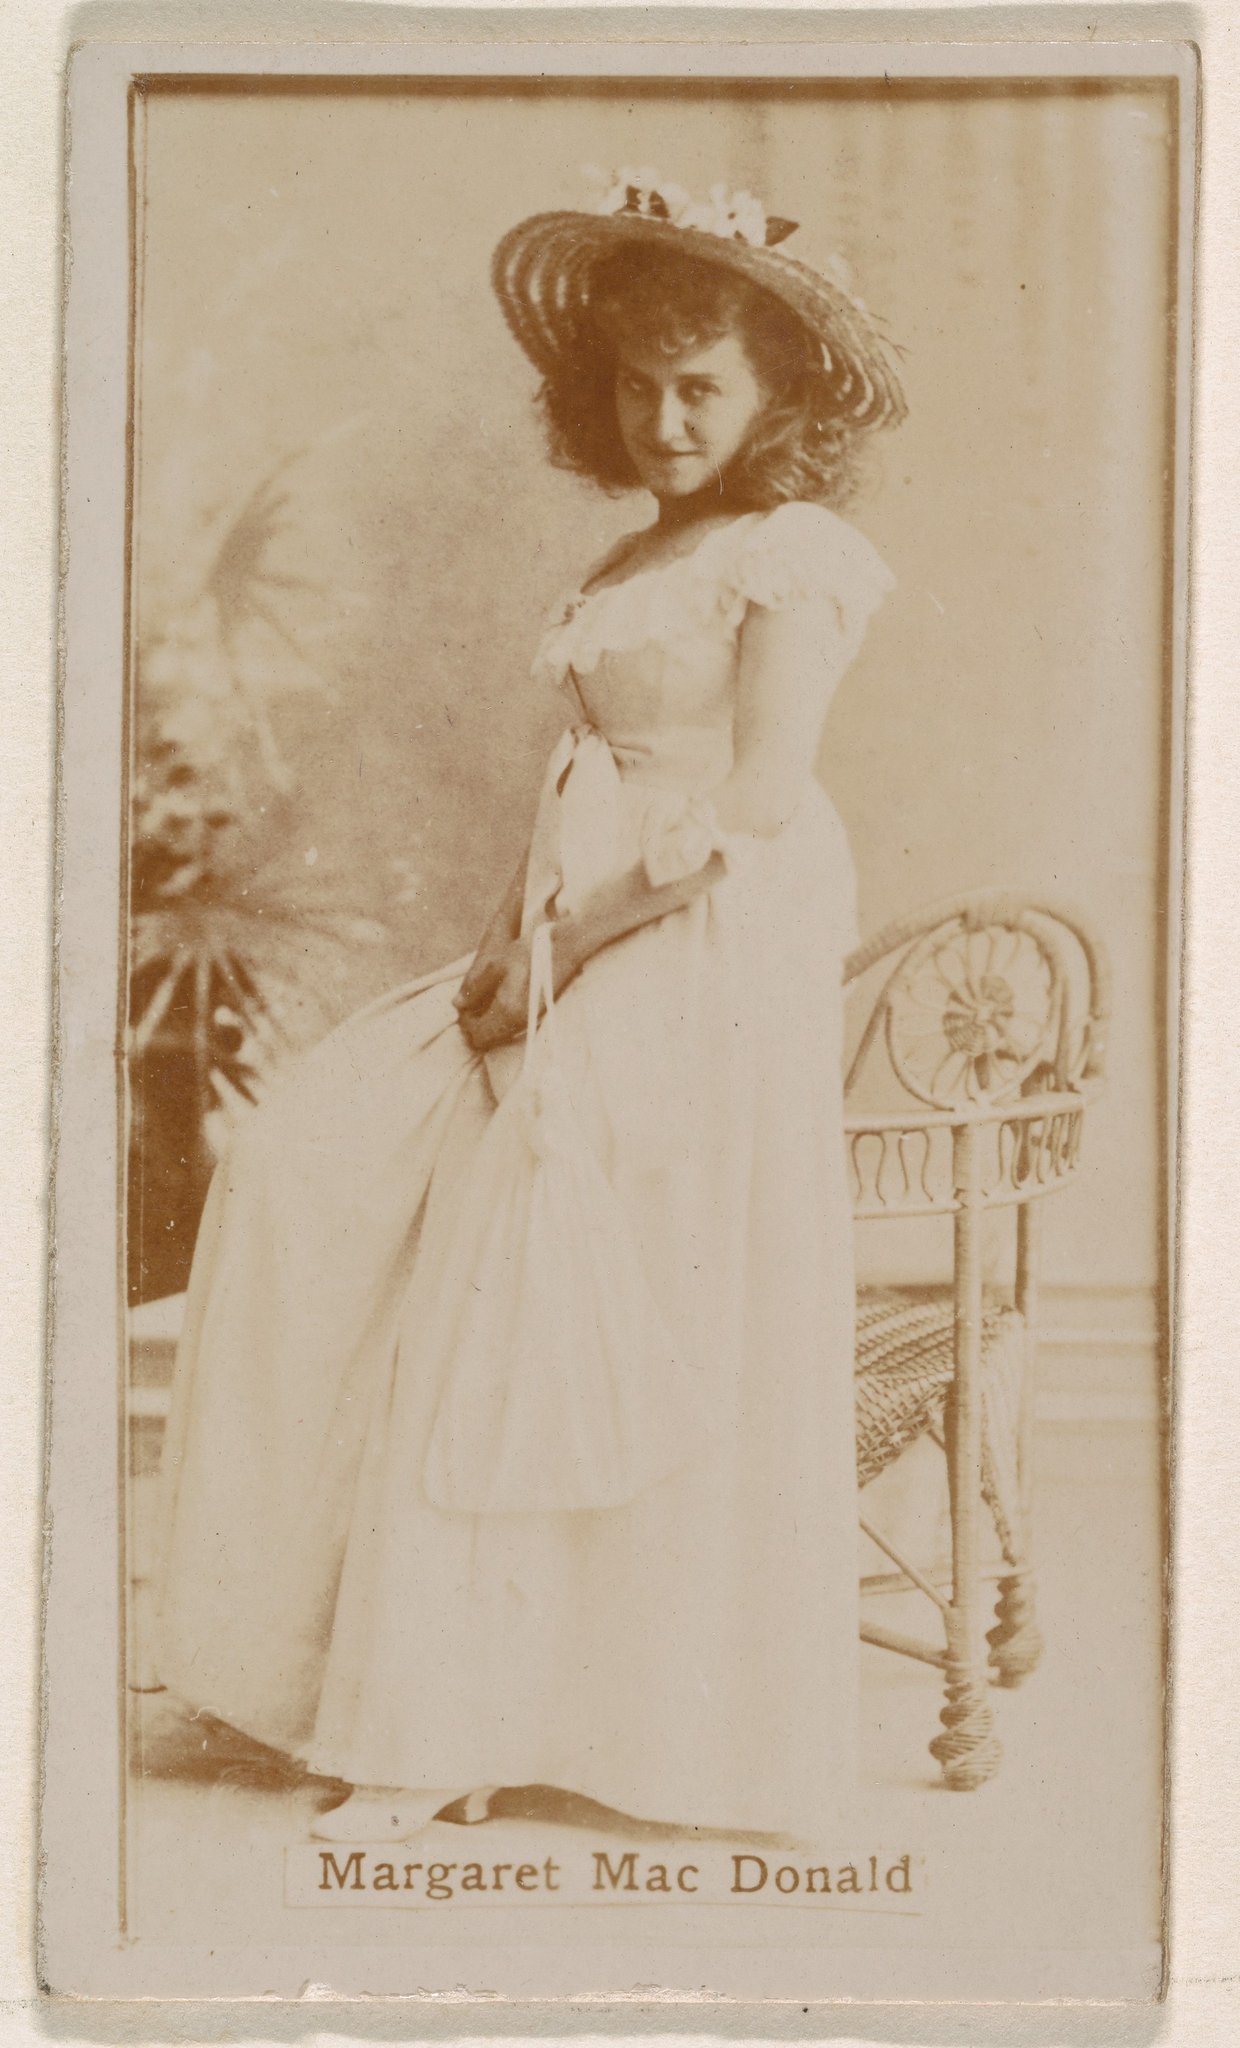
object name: photograph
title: Margaret MacDonald, from the Actresses series (N245) issued by Kinney Brothers to promote Sweet Caporal Cigarettes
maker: kinney brothers tobacco company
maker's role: publisher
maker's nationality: american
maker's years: 1869-2011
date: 1890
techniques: albumen silver print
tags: portraits,women,actresses